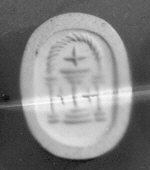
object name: stamp seal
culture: sasanian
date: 201-700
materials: stone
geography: iran or mesopotamia